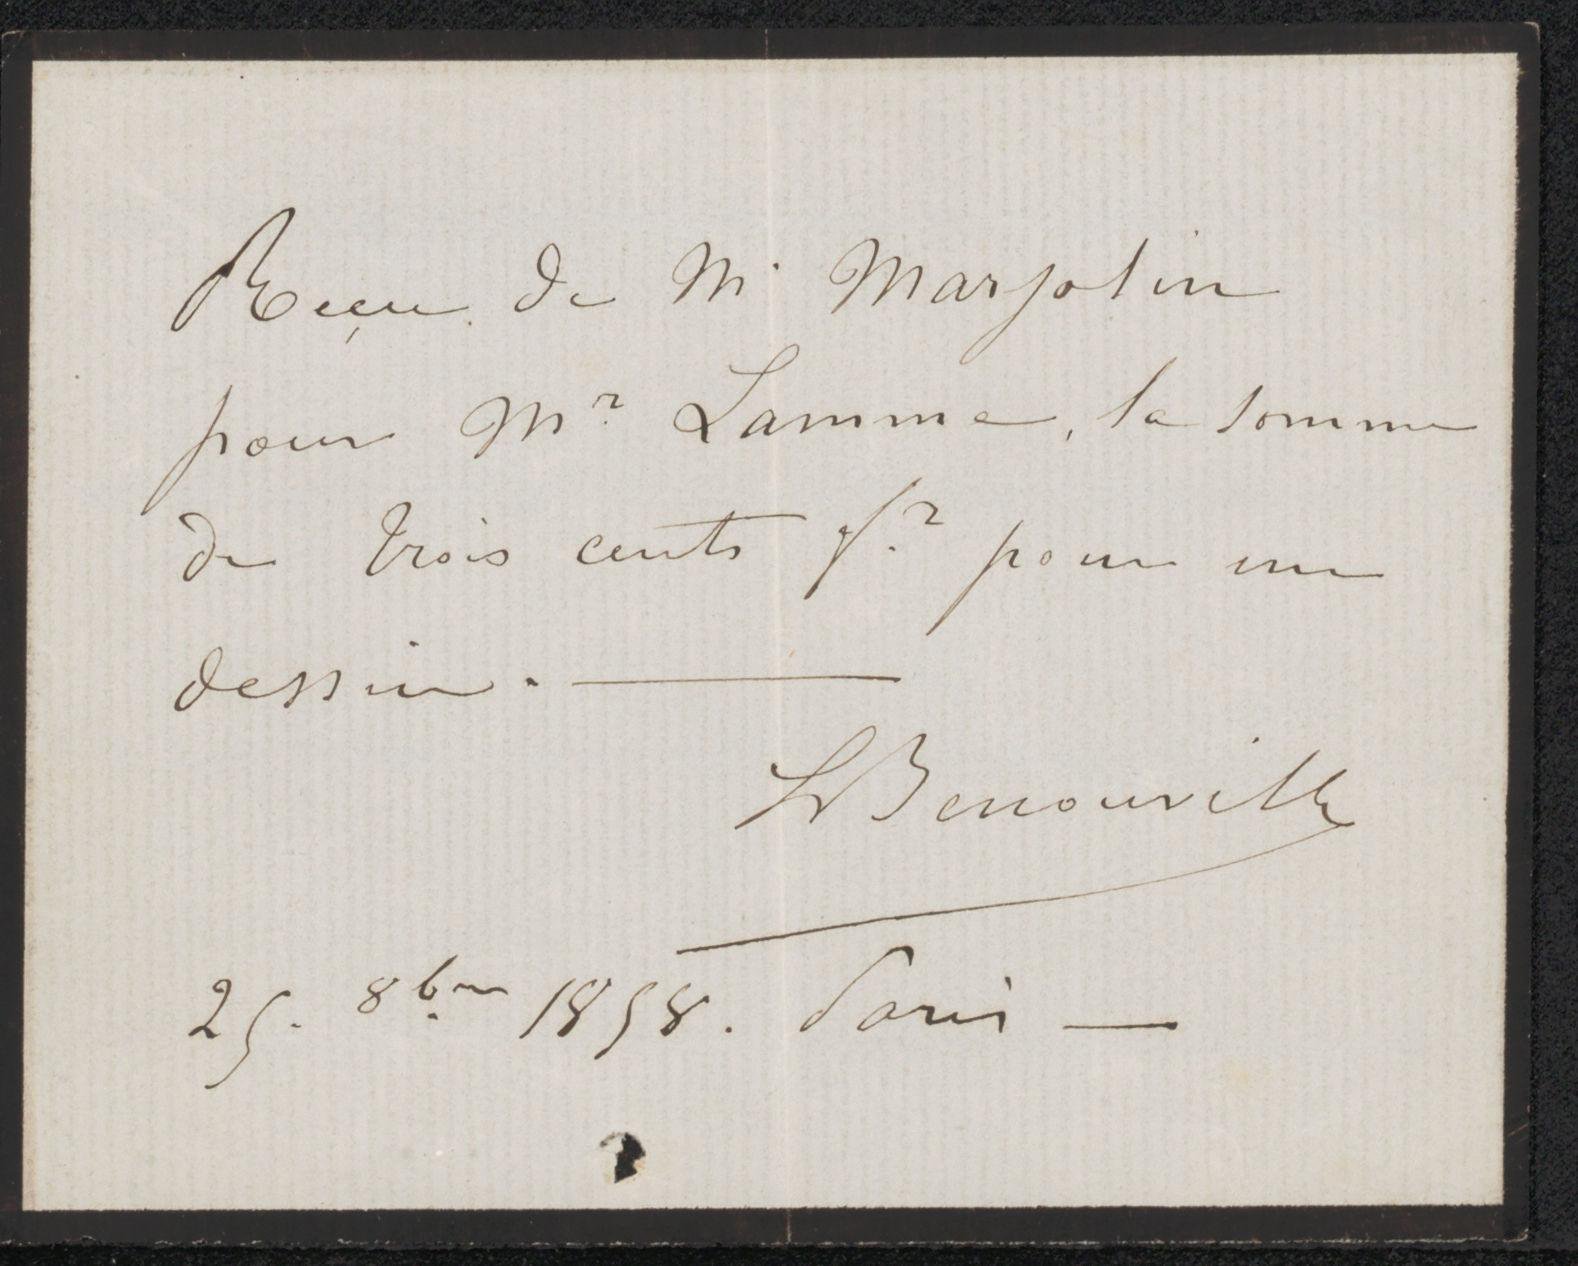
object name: ontvangstbewijs, kwitantie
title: Kwitantie voor Ary Johannes Lamme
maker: léon benouville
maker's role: painter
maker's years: 1821-1859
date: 1858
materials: ink, paper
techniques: pen, writing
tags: dordrecht, print maker, draughtsman, ary johannes lamme, art trade, art shop, drawing, money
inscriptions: collector's mark: Lugt 2228